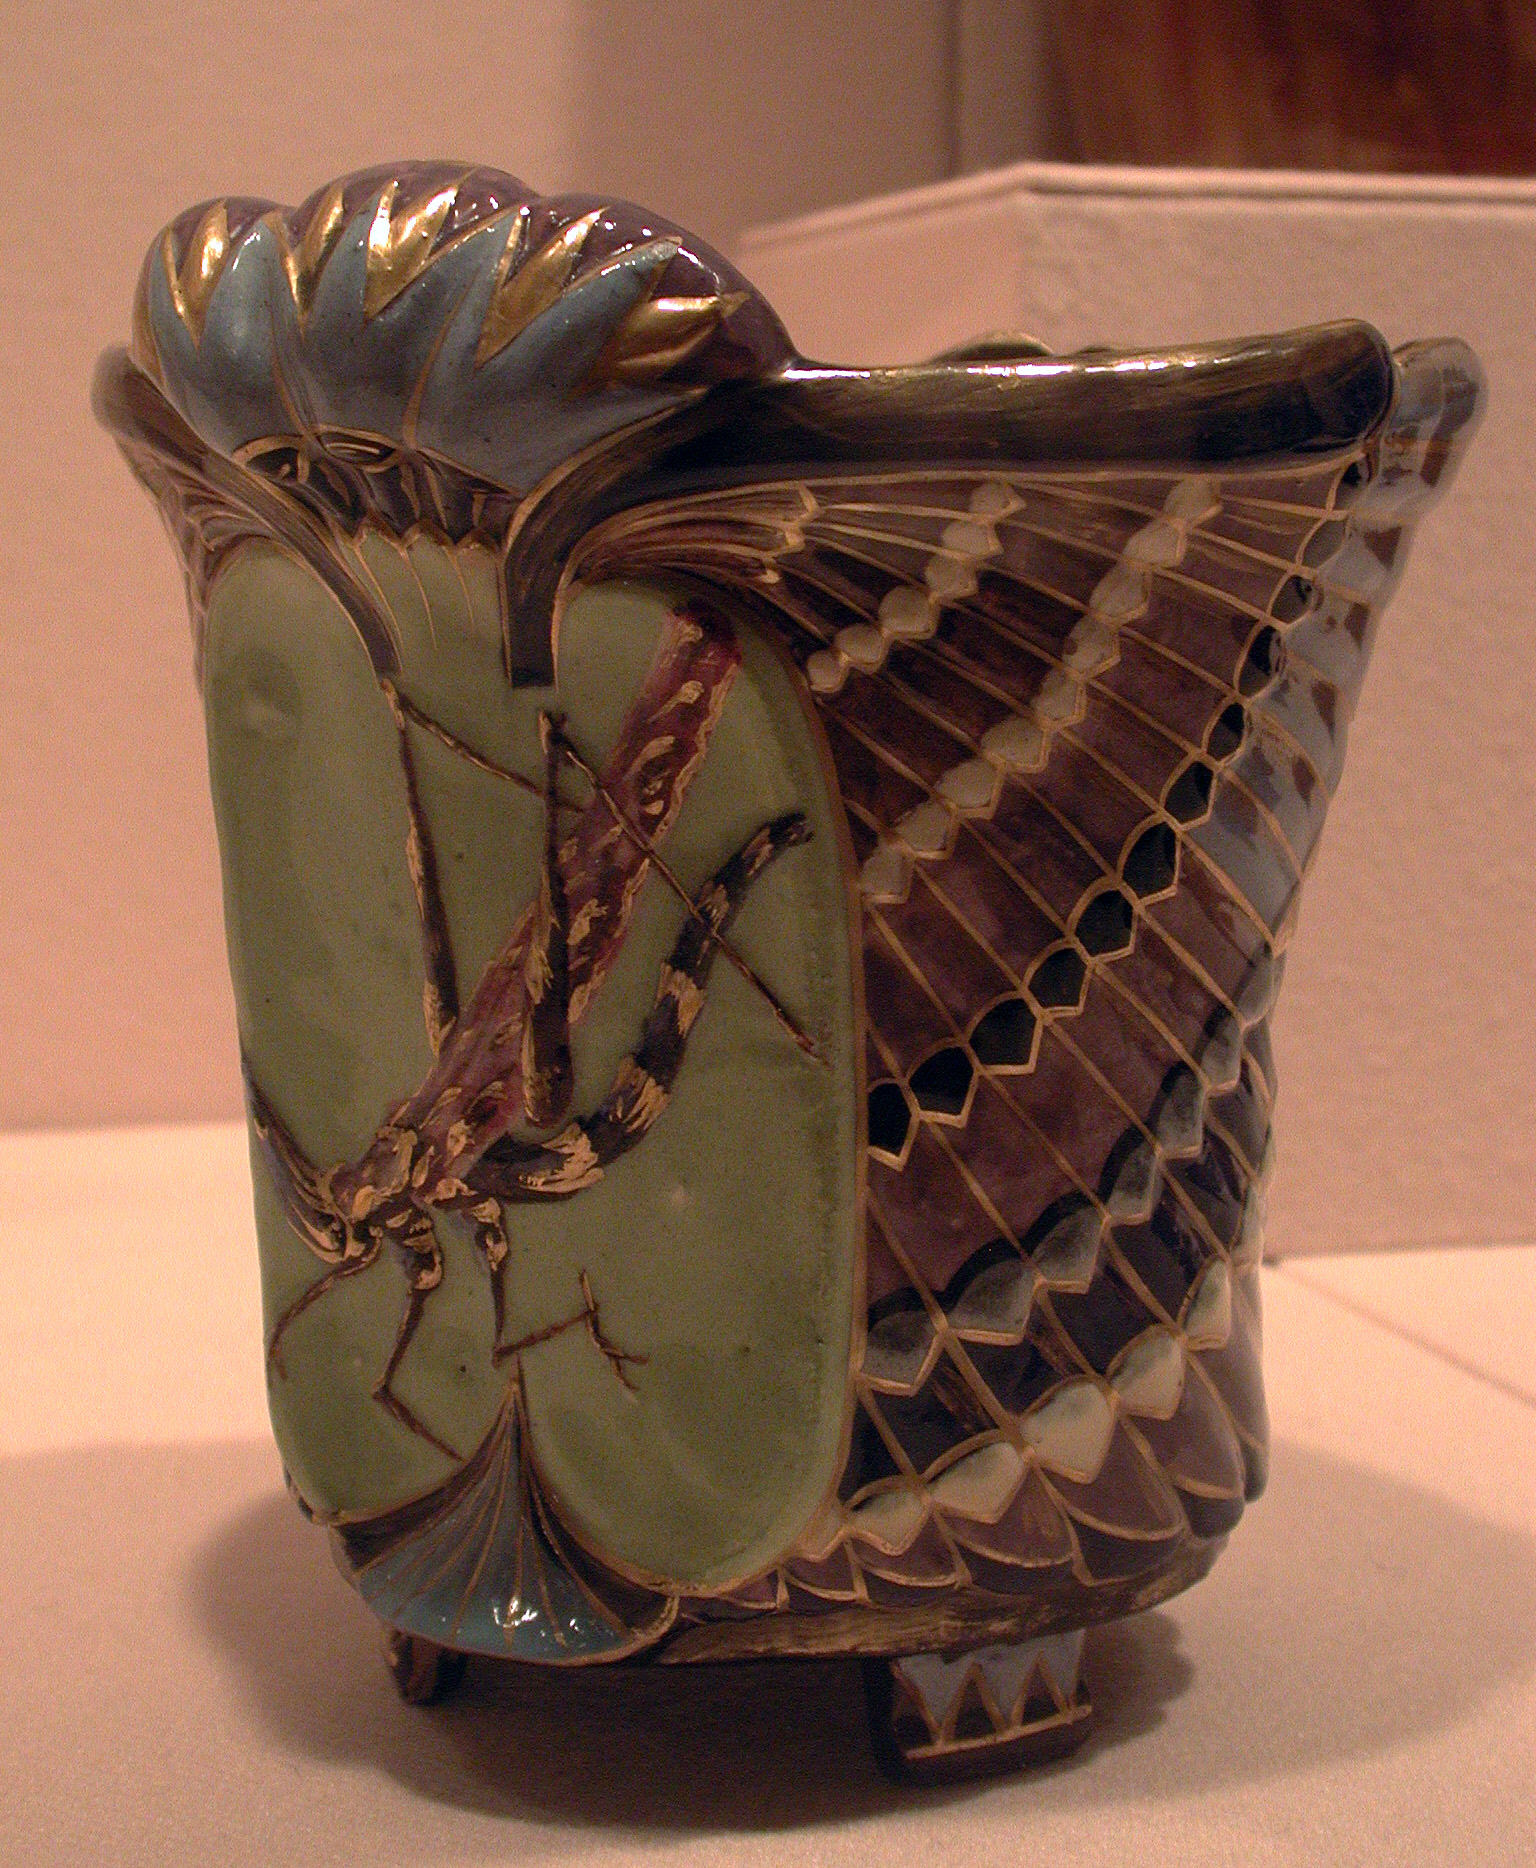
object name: vase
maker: emile gallé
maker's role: maker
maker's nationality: french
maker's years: 1846-1904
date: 1880-1885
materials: earthenware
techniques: glazing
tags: insects